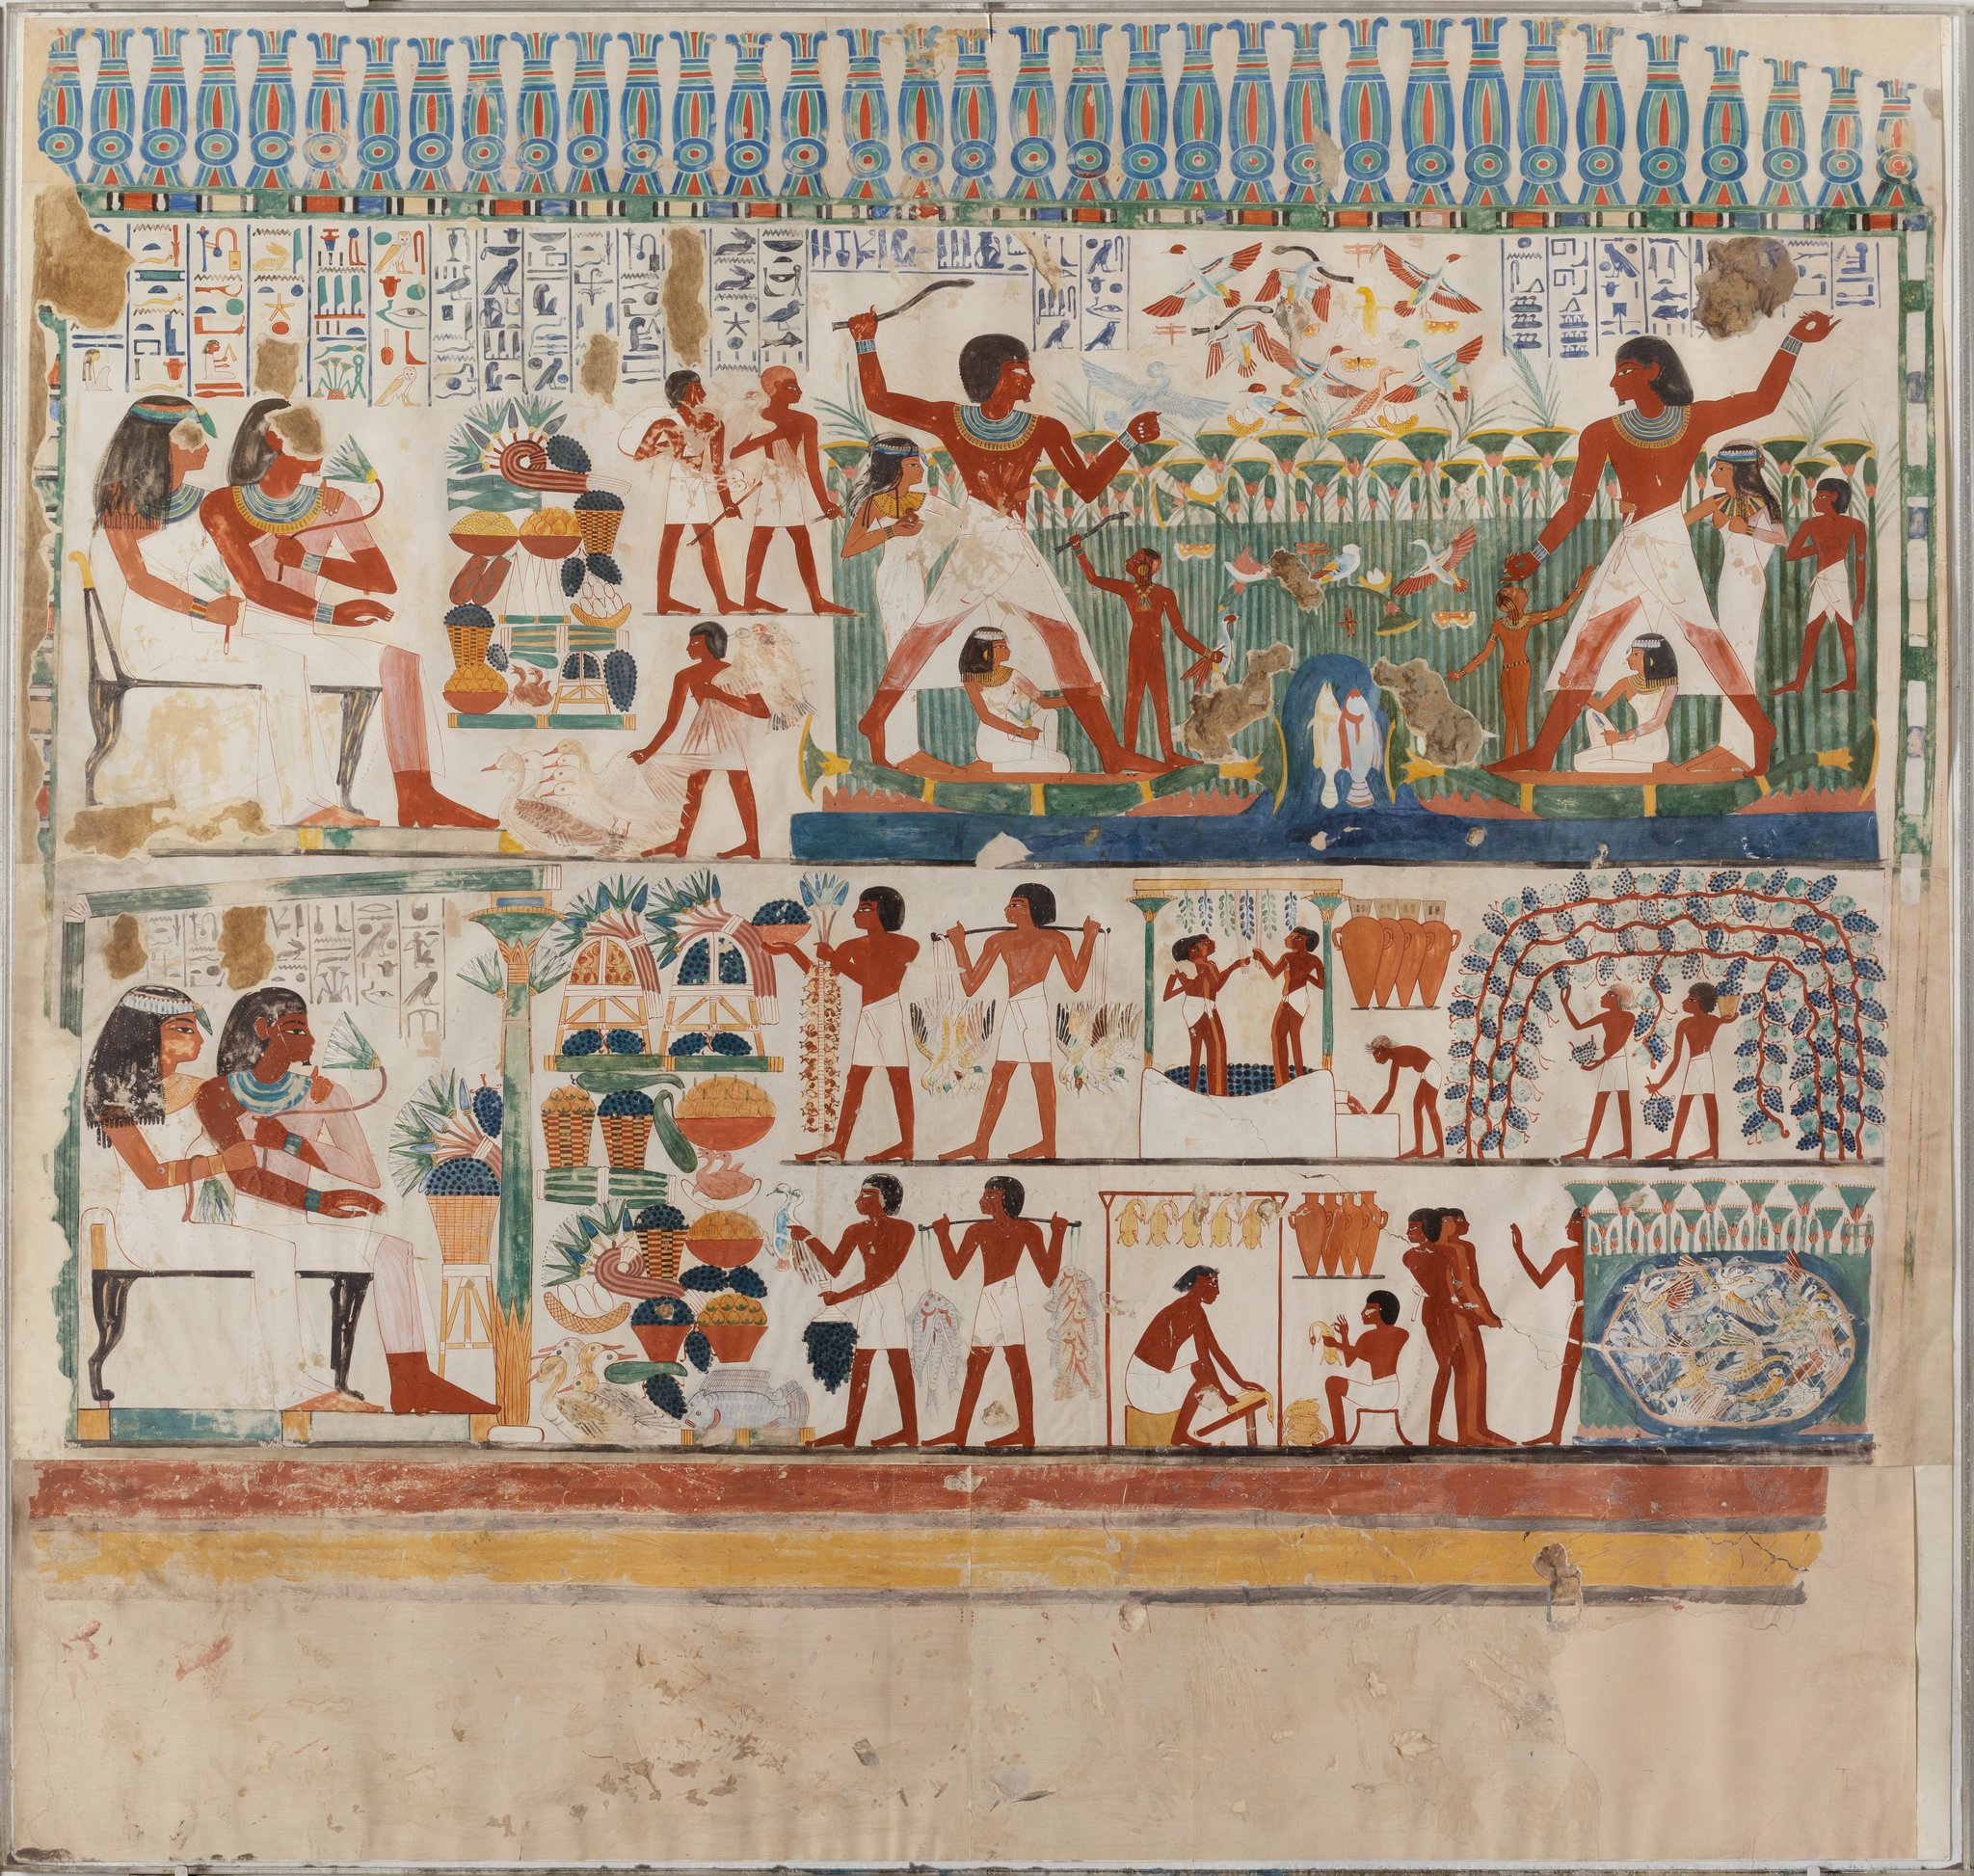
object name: facsimile, tt 52, fishing, fowling, wine making, clap net,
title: North Side of the West Wall of Nakht's Offering Chapel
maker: norman de garis davies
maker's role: artist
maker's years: 1865-1941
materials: paper, paint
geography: egypt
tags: food,birds,grapes,wine,men,women,hieroglyphs,hunting,fish